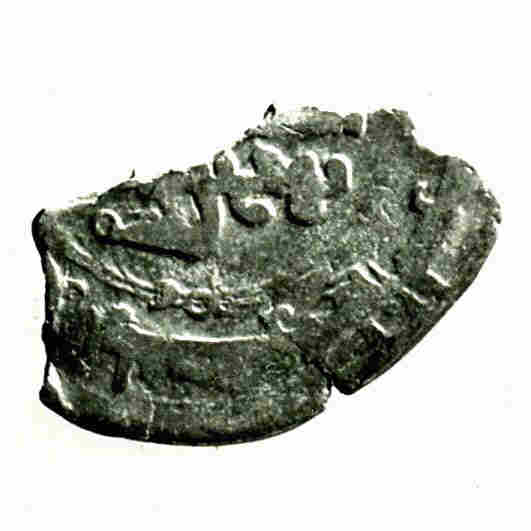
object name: coin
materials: silver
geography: iran